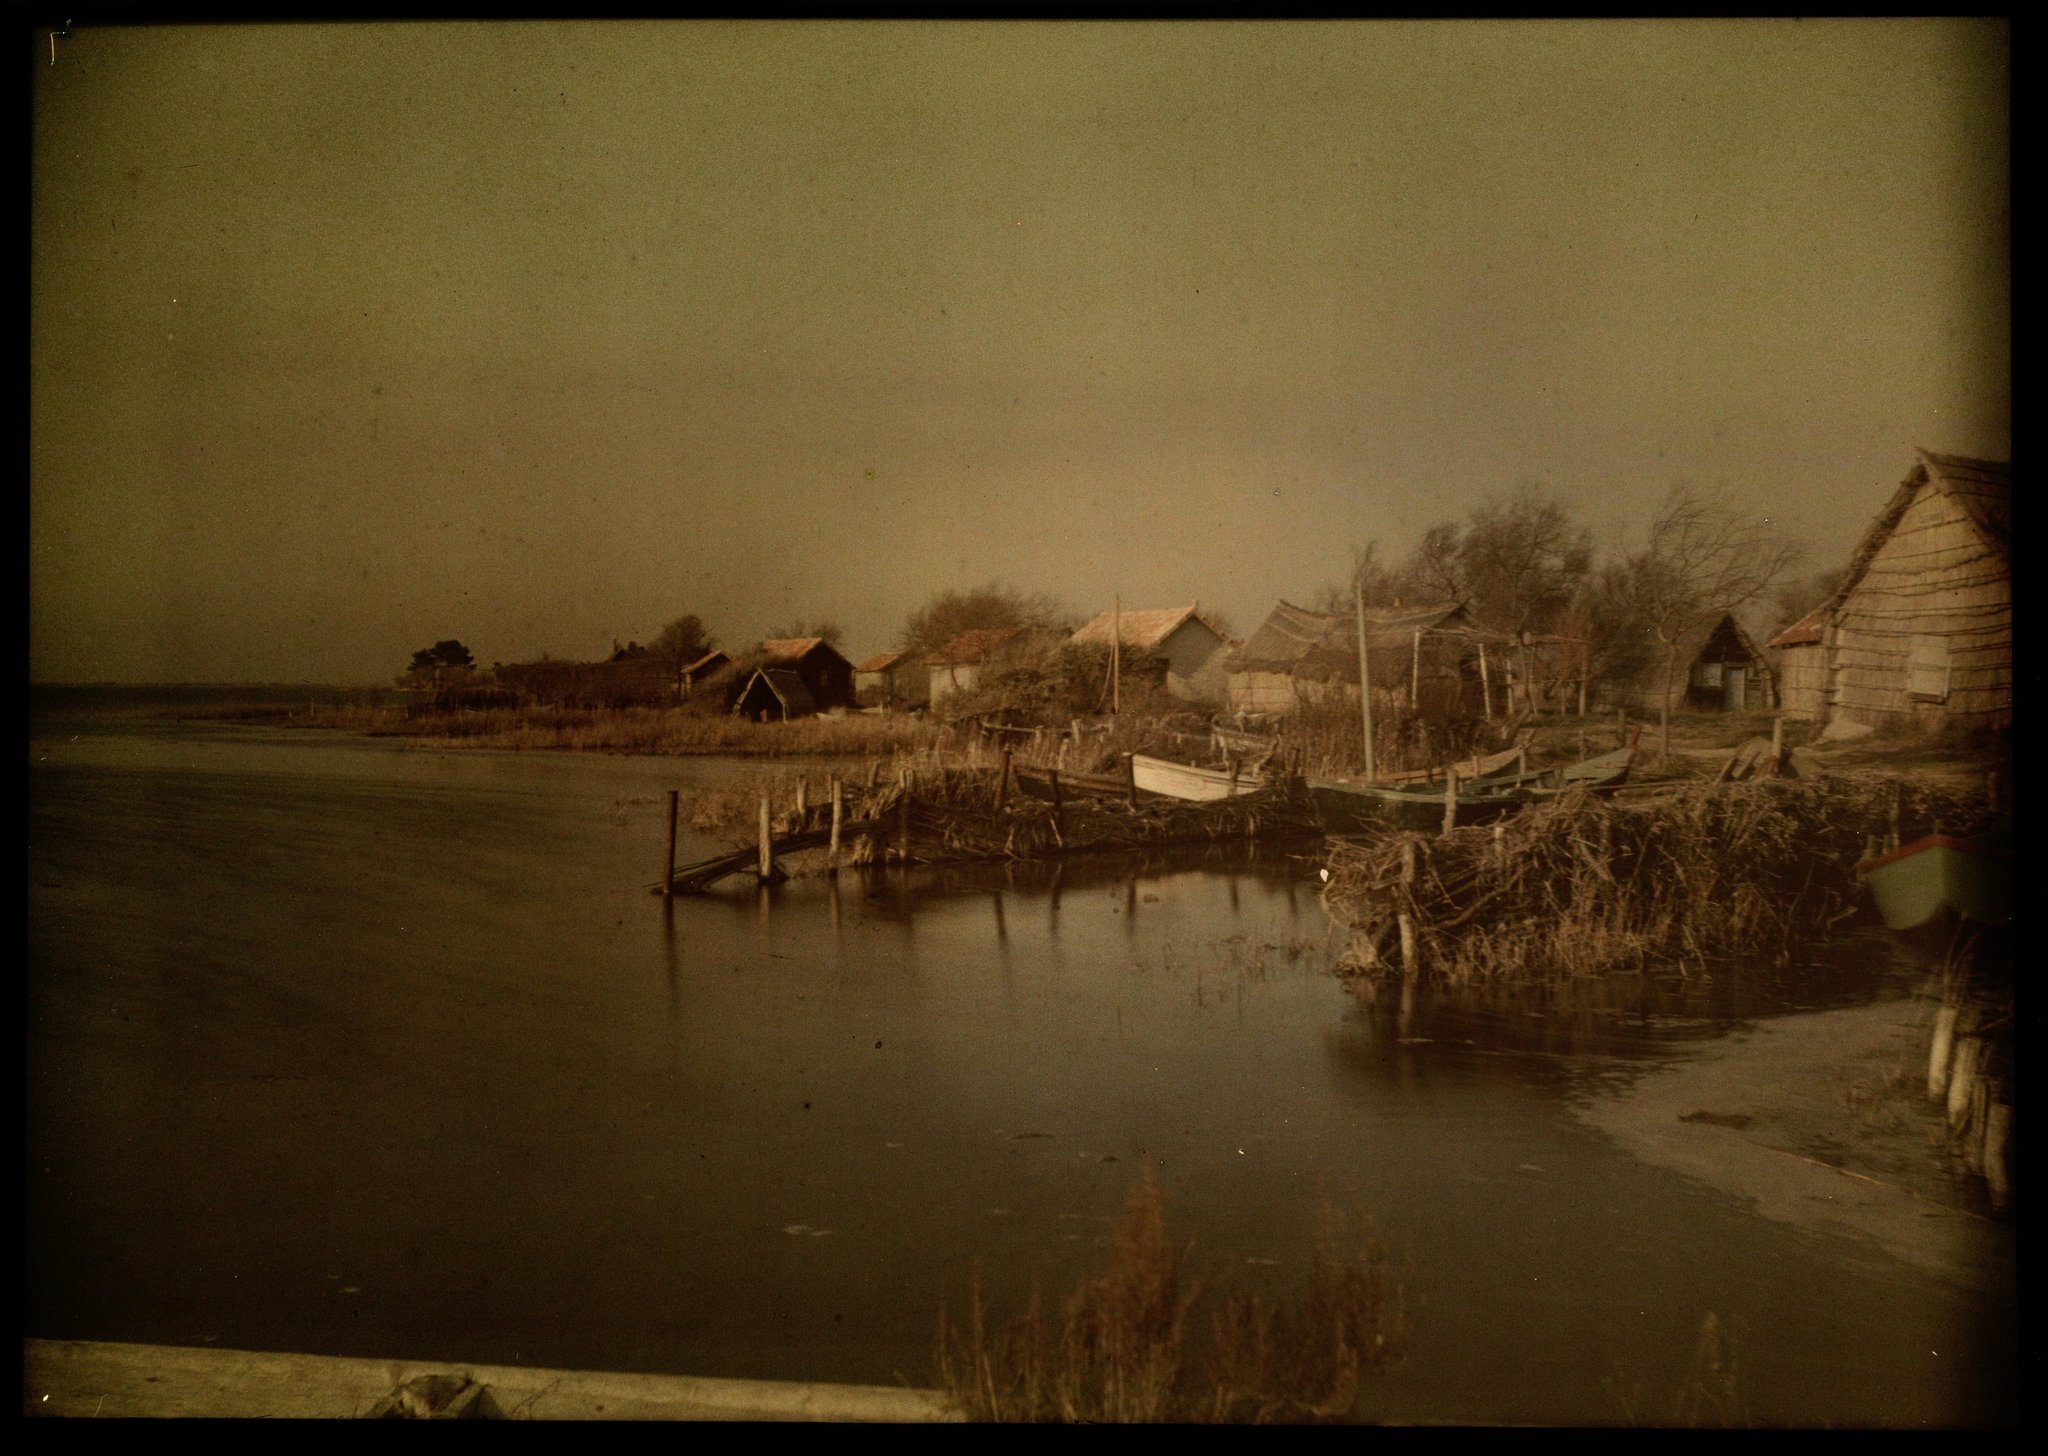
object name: glasdia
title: Rietlandschap met water en boerderijen of schuren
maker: Anonymous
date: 1907-1935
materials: glass, paper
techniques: autochrome process